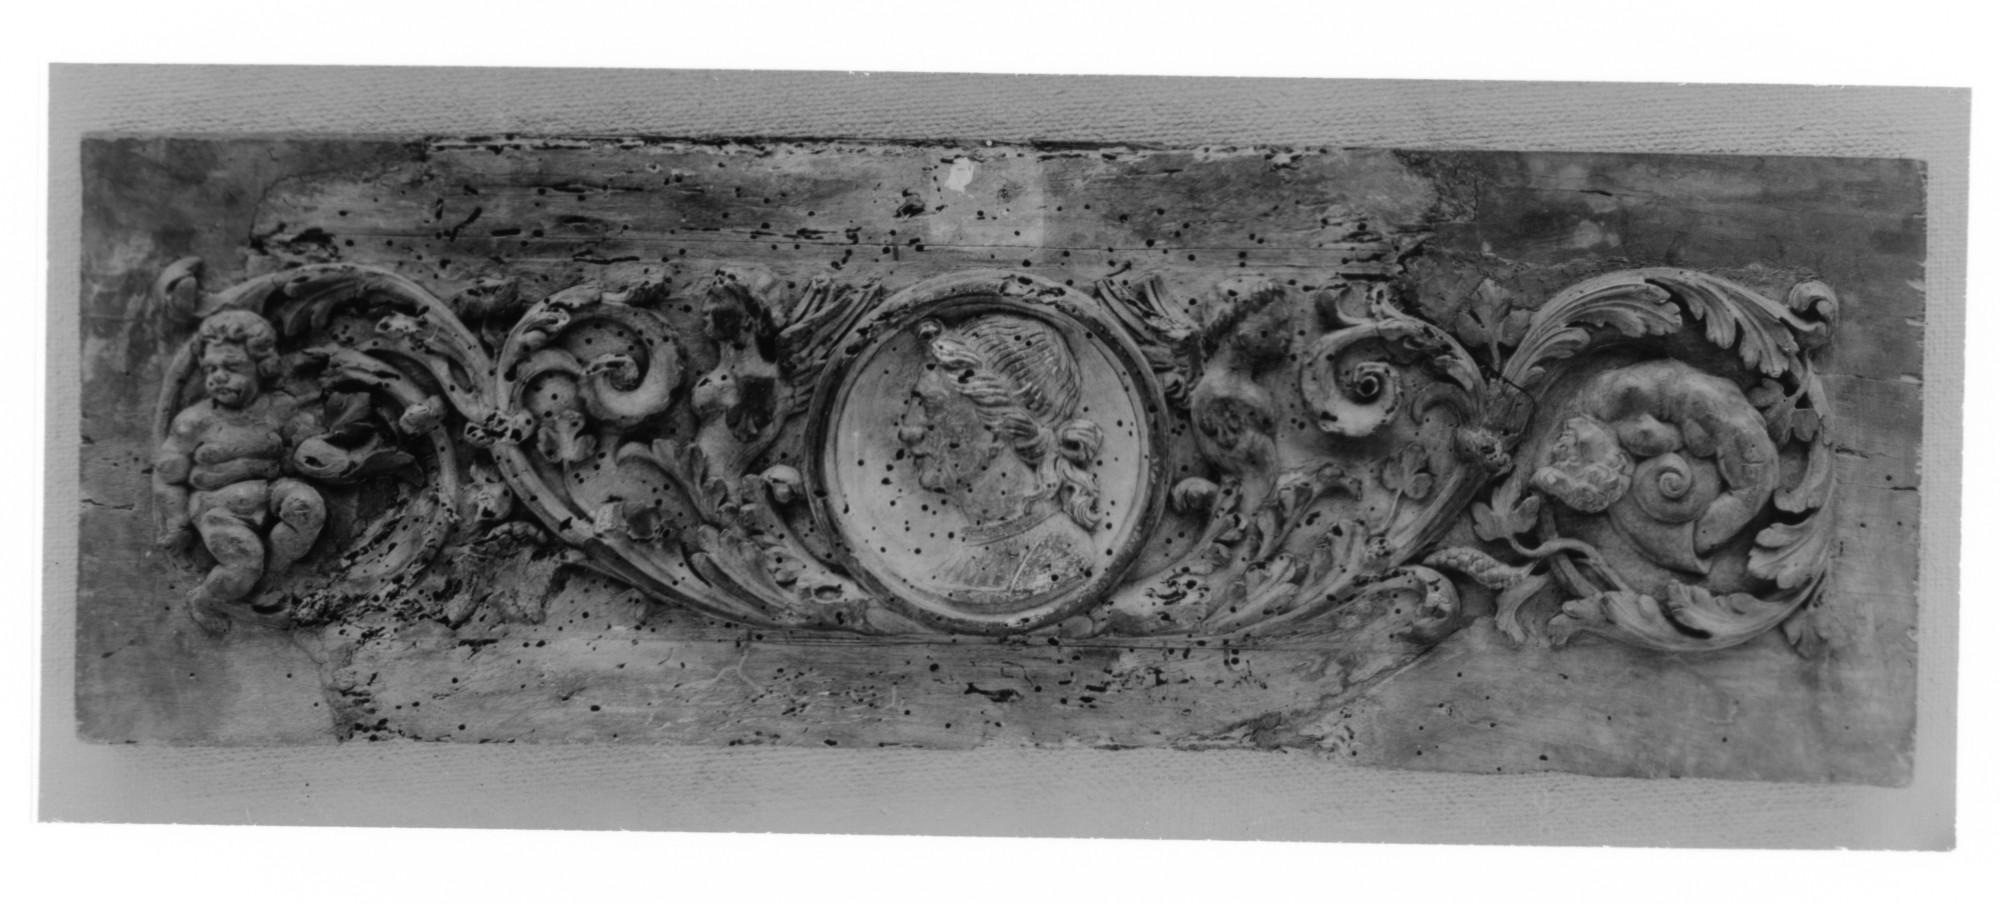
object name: frieze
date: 1501-1550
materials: wood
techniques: carving